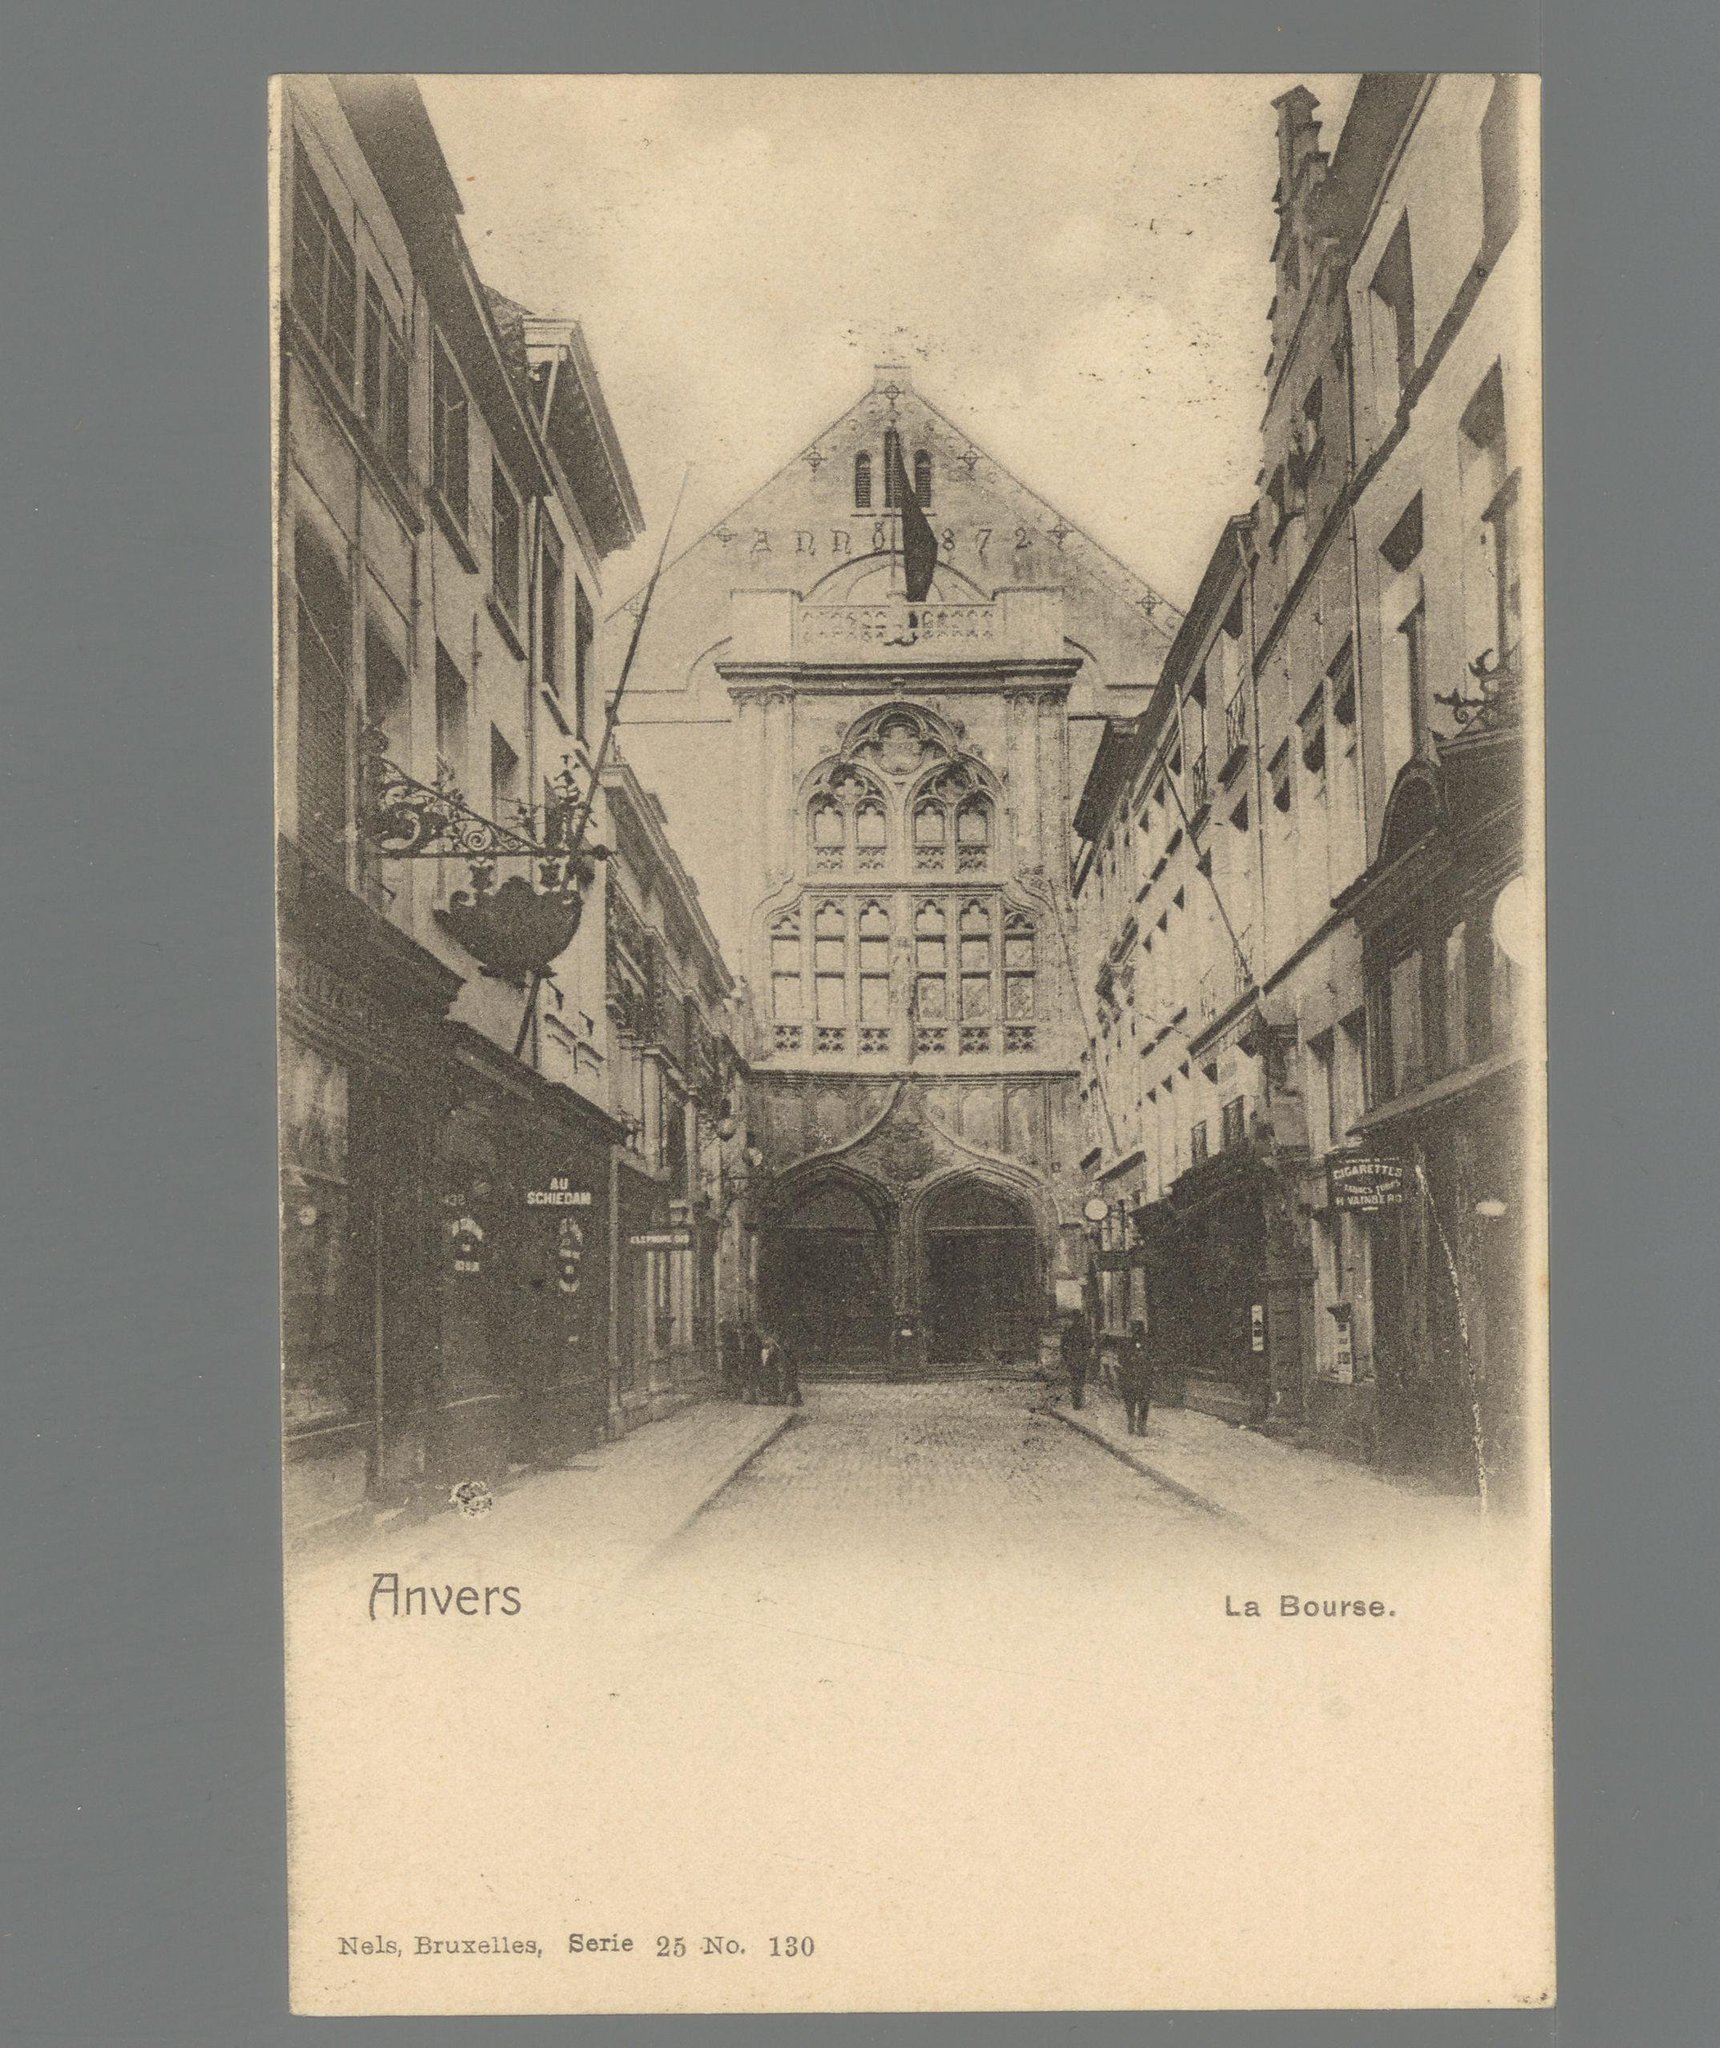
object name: photomechanical print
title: Anvers. La Bourse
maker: Anonymous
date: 1898-1902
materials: cardboard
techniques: photograph, writing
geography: brussels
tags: exchange, bourse, street (+ city(-scape) with figures, staffage)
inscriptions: postage stamp